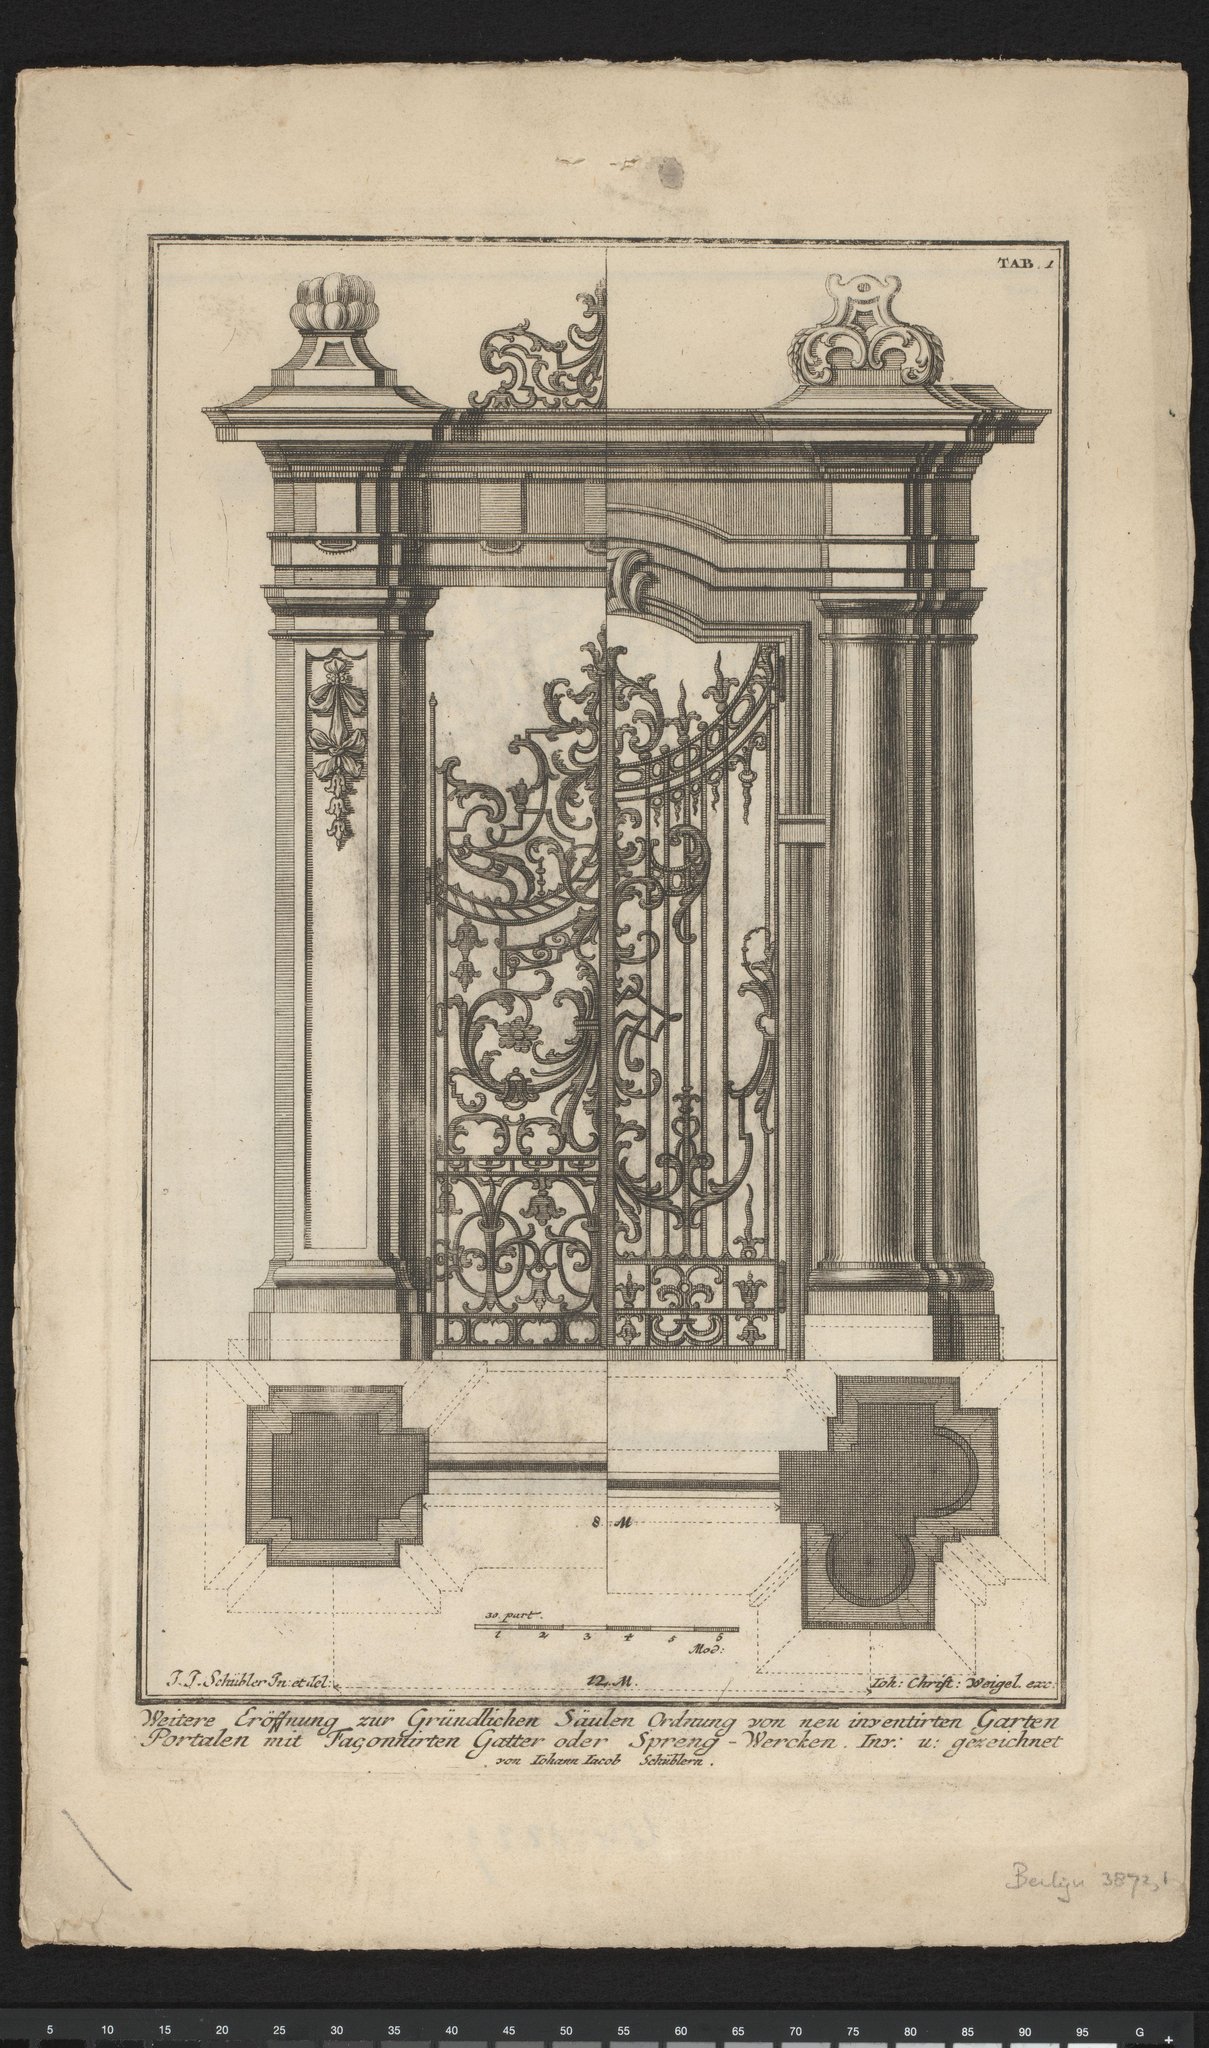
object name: ornament print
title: Weitere Eröffnung zur Gründlichen Säulen Ordnung von neu inventirten Garten Portalen (...)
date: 1699-1726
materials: paper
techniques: engraving, etching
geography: nuremberg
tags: fence, wall, paling, flowers ~ ornament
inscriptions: collector's mark: Lugt 2228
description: Prent uit: Schübler, Johann Jakob. Weitere Eröffnung zur Gründlichen Säulen Ordnung von neu inventirten Garten Portalen (...). [Neurenberg]: Weigel, Johann Christoph, [voor 1726].